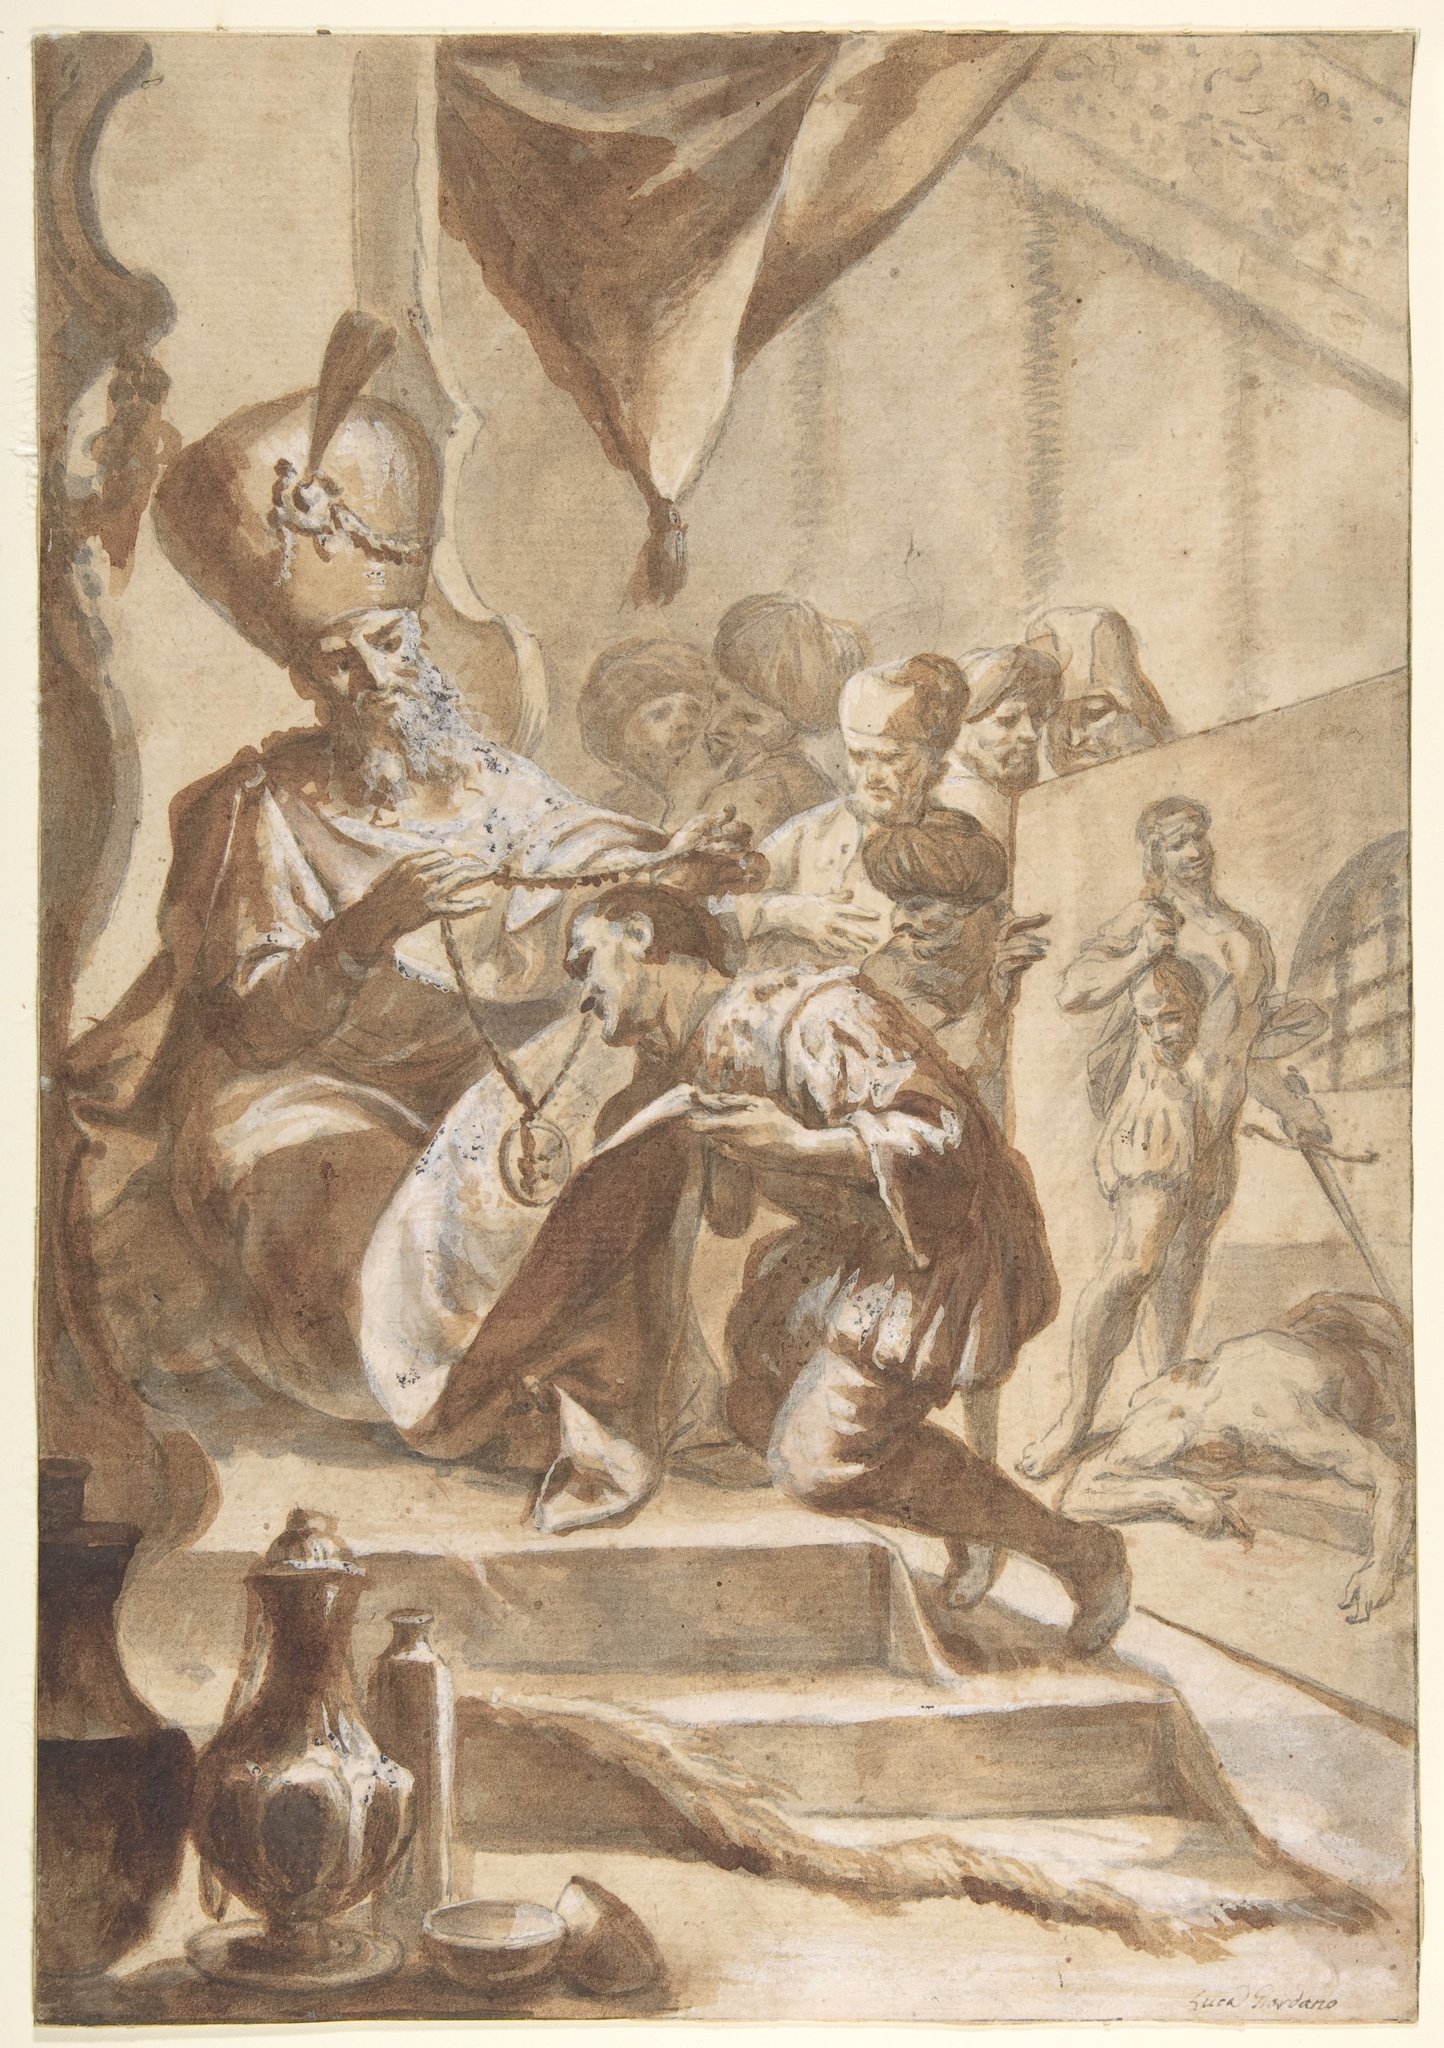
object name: drawing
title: The Painter Rewarded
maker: luca giordano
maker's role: artist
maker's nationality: italian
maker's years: 1634-1705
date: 1634-1705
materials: gouache, ink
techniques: brush, highlighting, pen, wash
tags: heads,men,artists